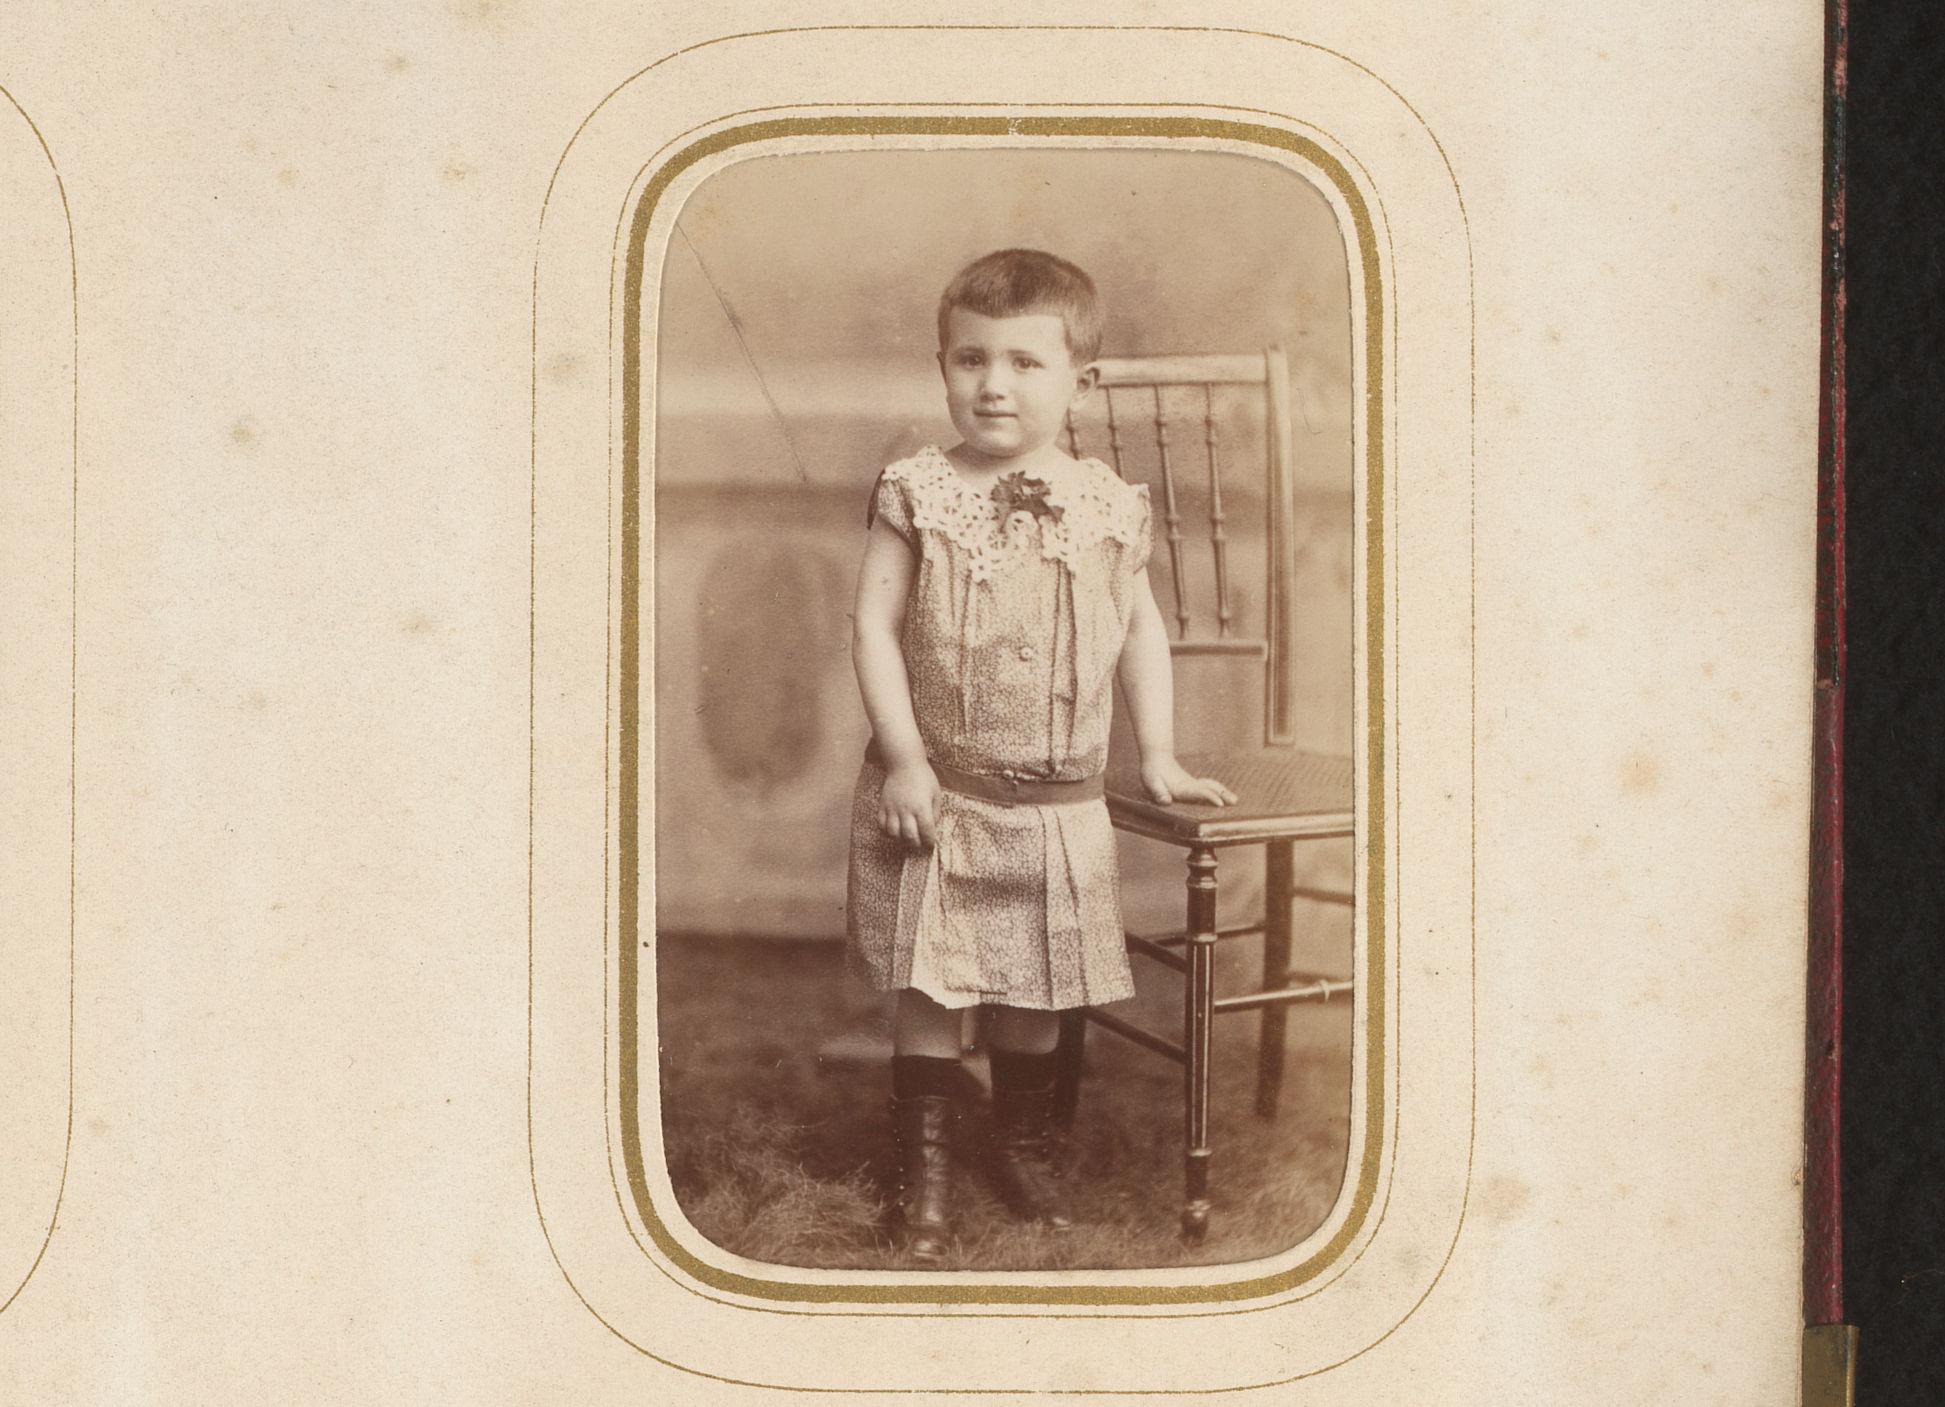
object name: album leaf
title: Portret van een kind, staand bij een stoel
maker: Anonymous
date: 1860-1890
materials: cardboard, photographic support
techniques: albumen print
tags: child